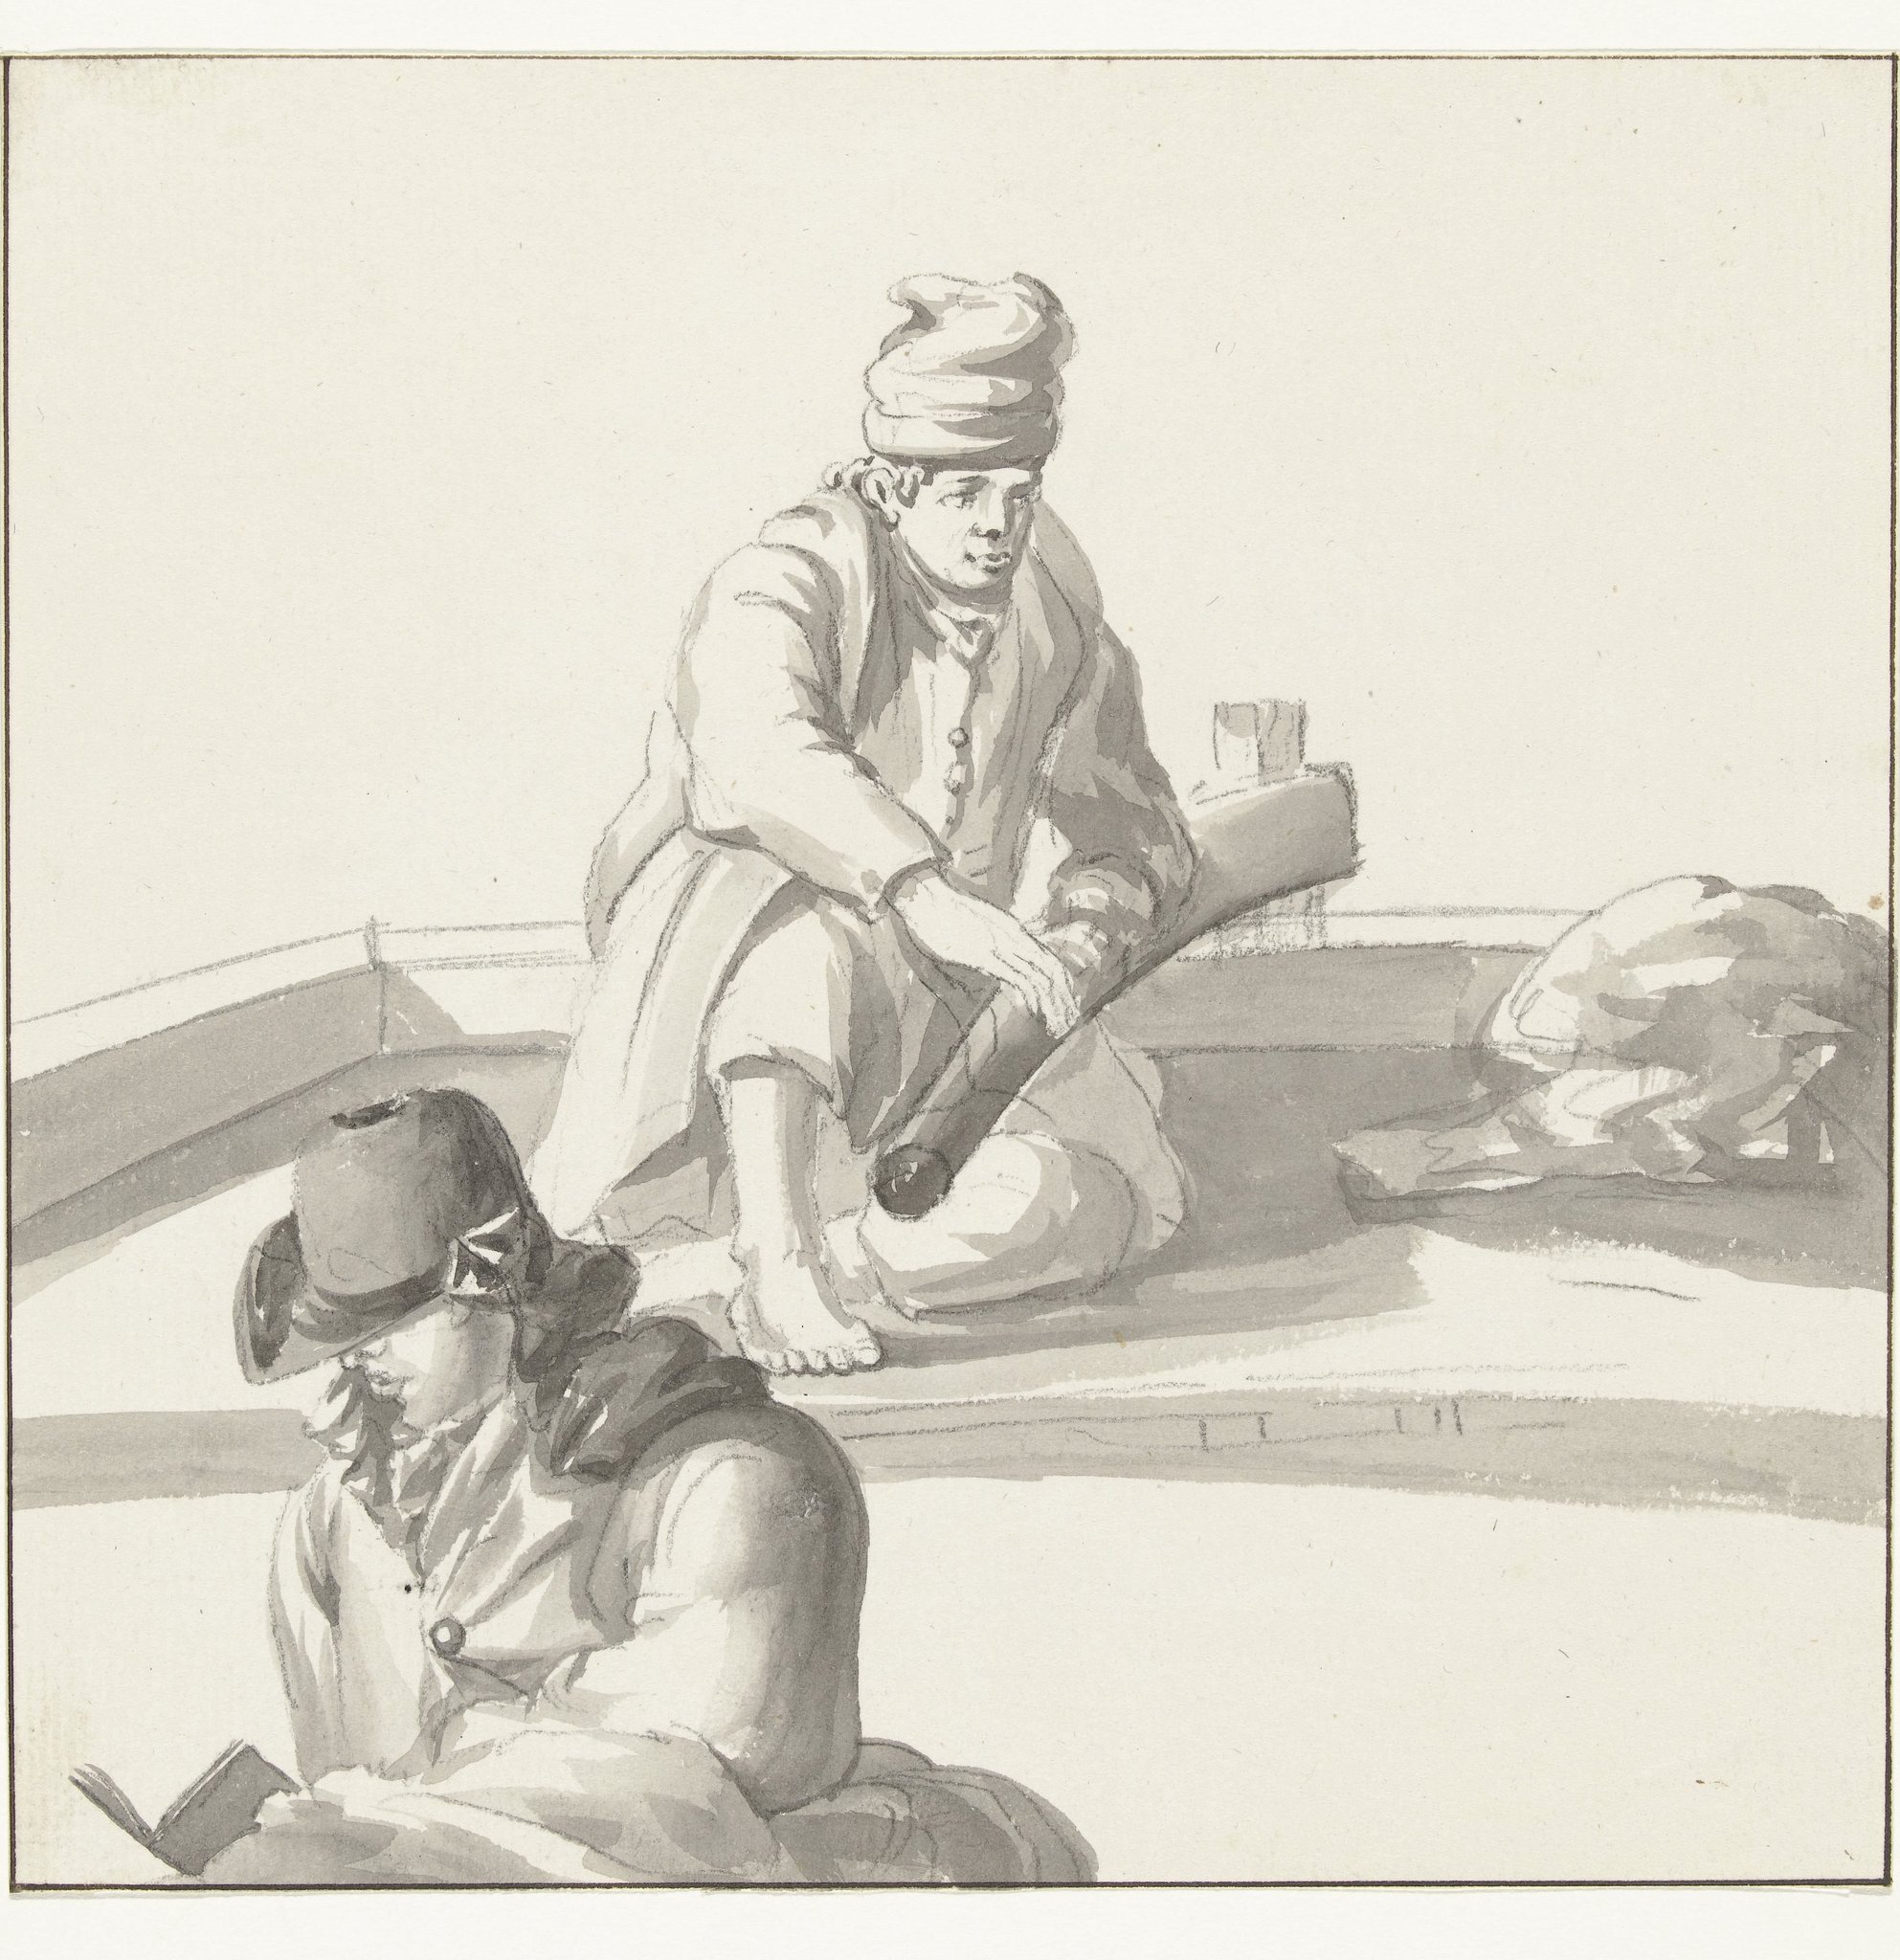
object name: drawing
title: Voyage en Italie, en Sicile et à Malte - 1778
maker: louis ducros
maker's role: draughtsman, print maker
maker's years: 1748-1810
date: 1778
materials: chalk, paper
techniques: brush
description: Tekening uit het album 'Voyage en Italie, en Sicile et à Malte', 1778.